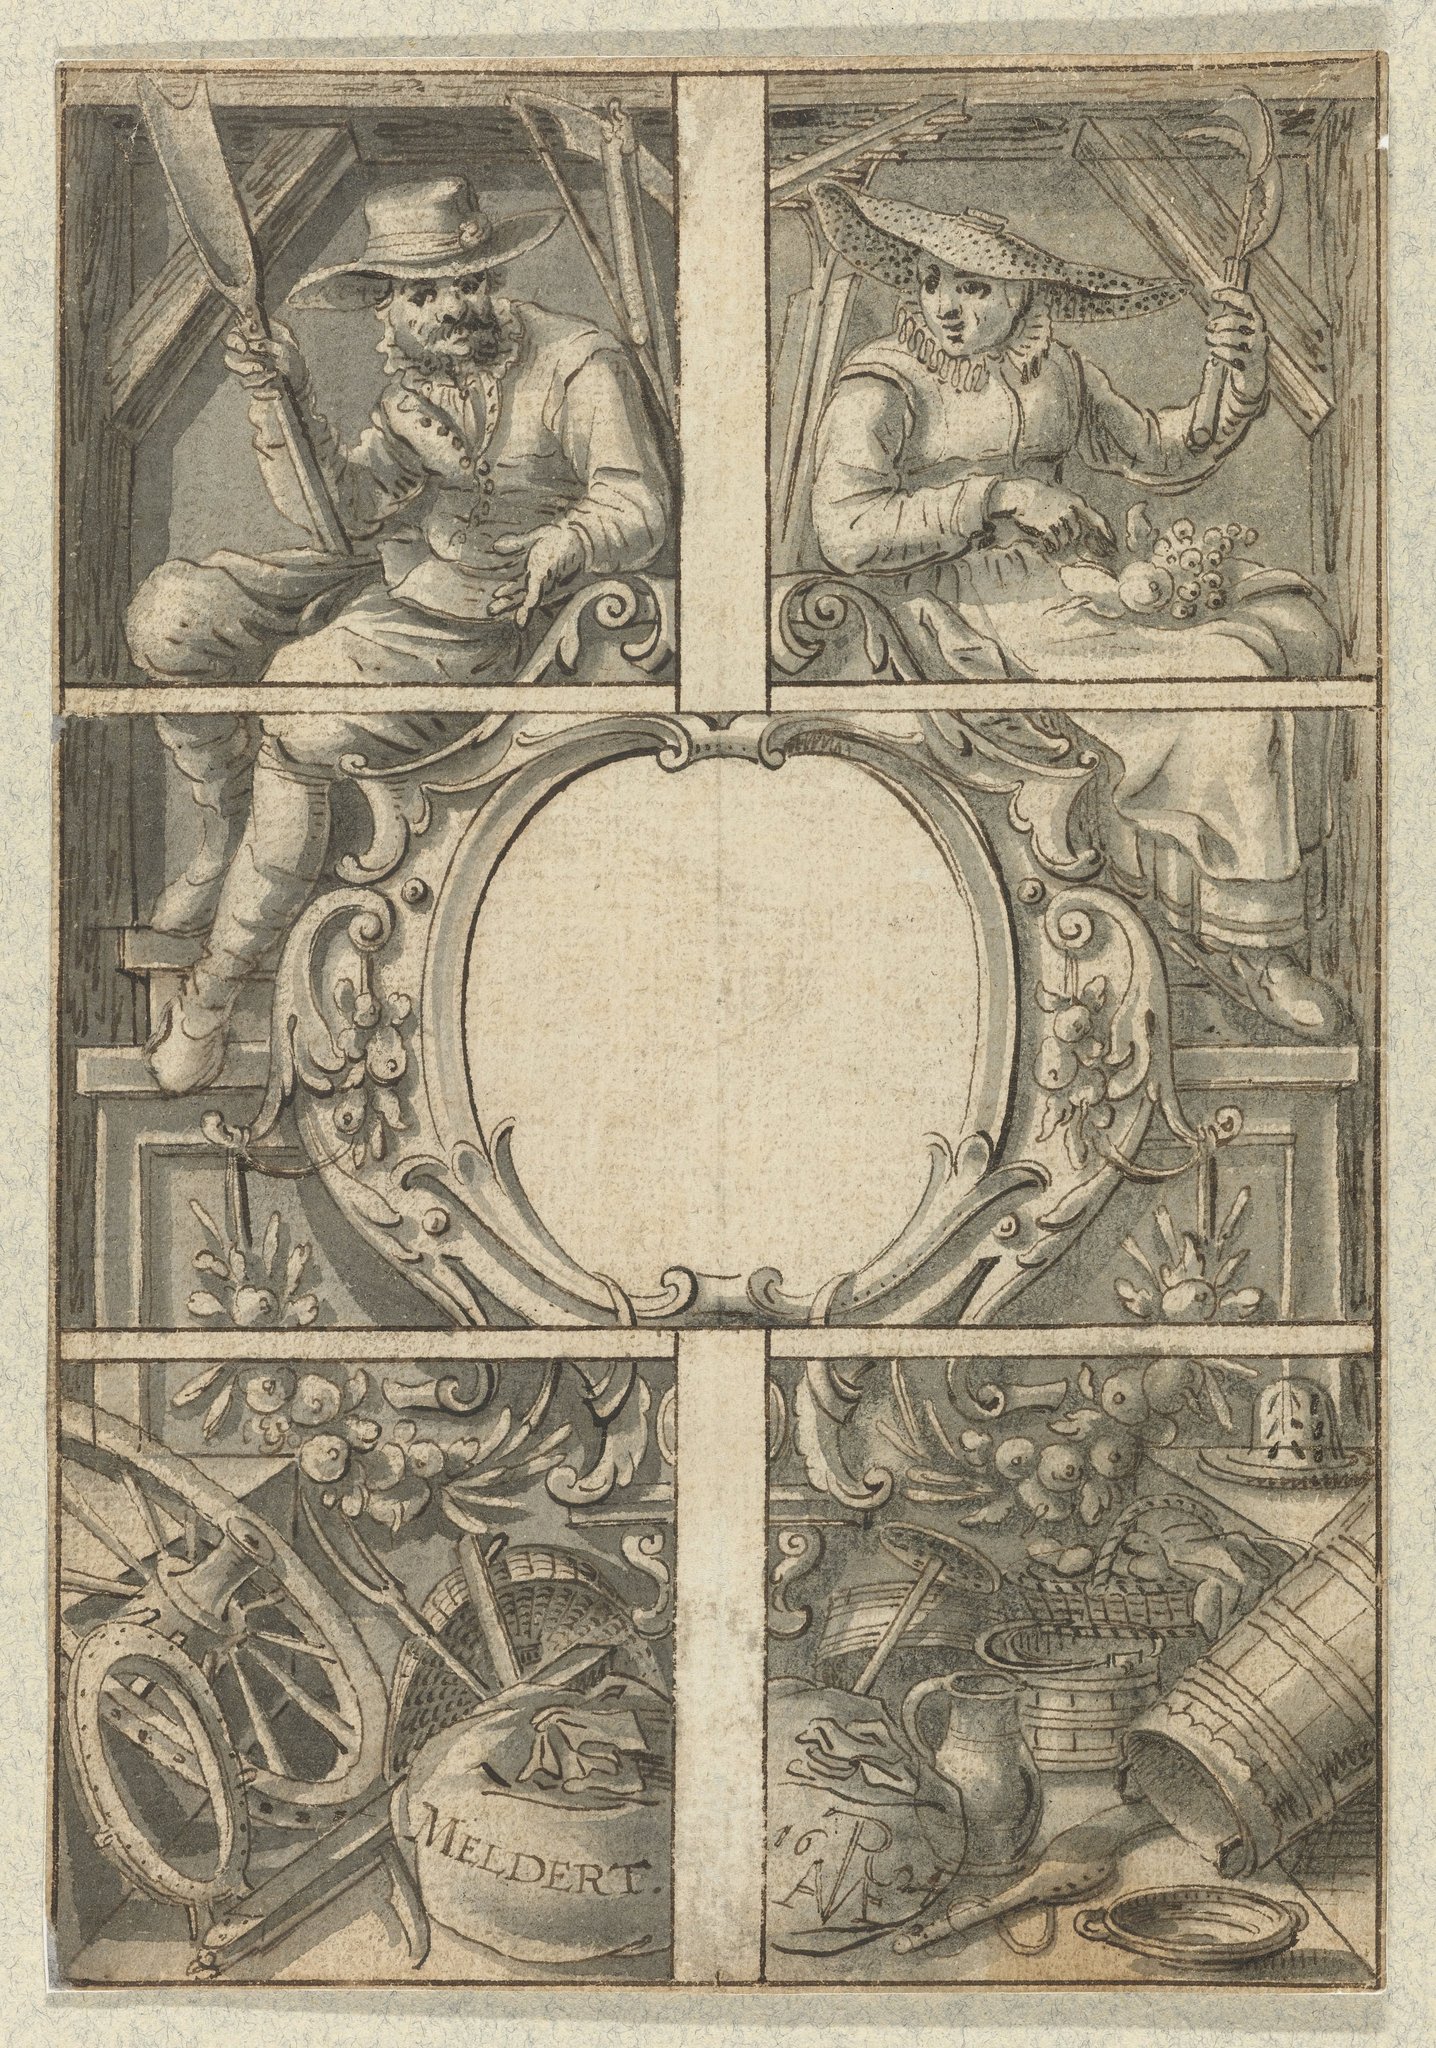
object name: drawing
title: Allegory of Farming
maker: pieter van meldert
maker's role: print maker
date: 1624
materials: ink, paper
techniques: brush, pen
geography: middelburg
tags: farmers, farmers - aa - female farmer, farmer's wife, agricultural implements, cattle-breeding, livestock industry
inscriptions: signature: ‘Meldert’, signature and date: ‘PvM 1624’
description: At the upper left is a farmer with a threshing flail and scythe, and beside him at the upper right a farmer’s wife with a sickle and hoe. The division of the composition into a vertical and two horizontal bands suggests that the drawing served as a design for a stained-glass window. This is the only known work by the glass painter Pieter van Meldert, who was active in Zeeland. None of his stained-glass windows have survived.